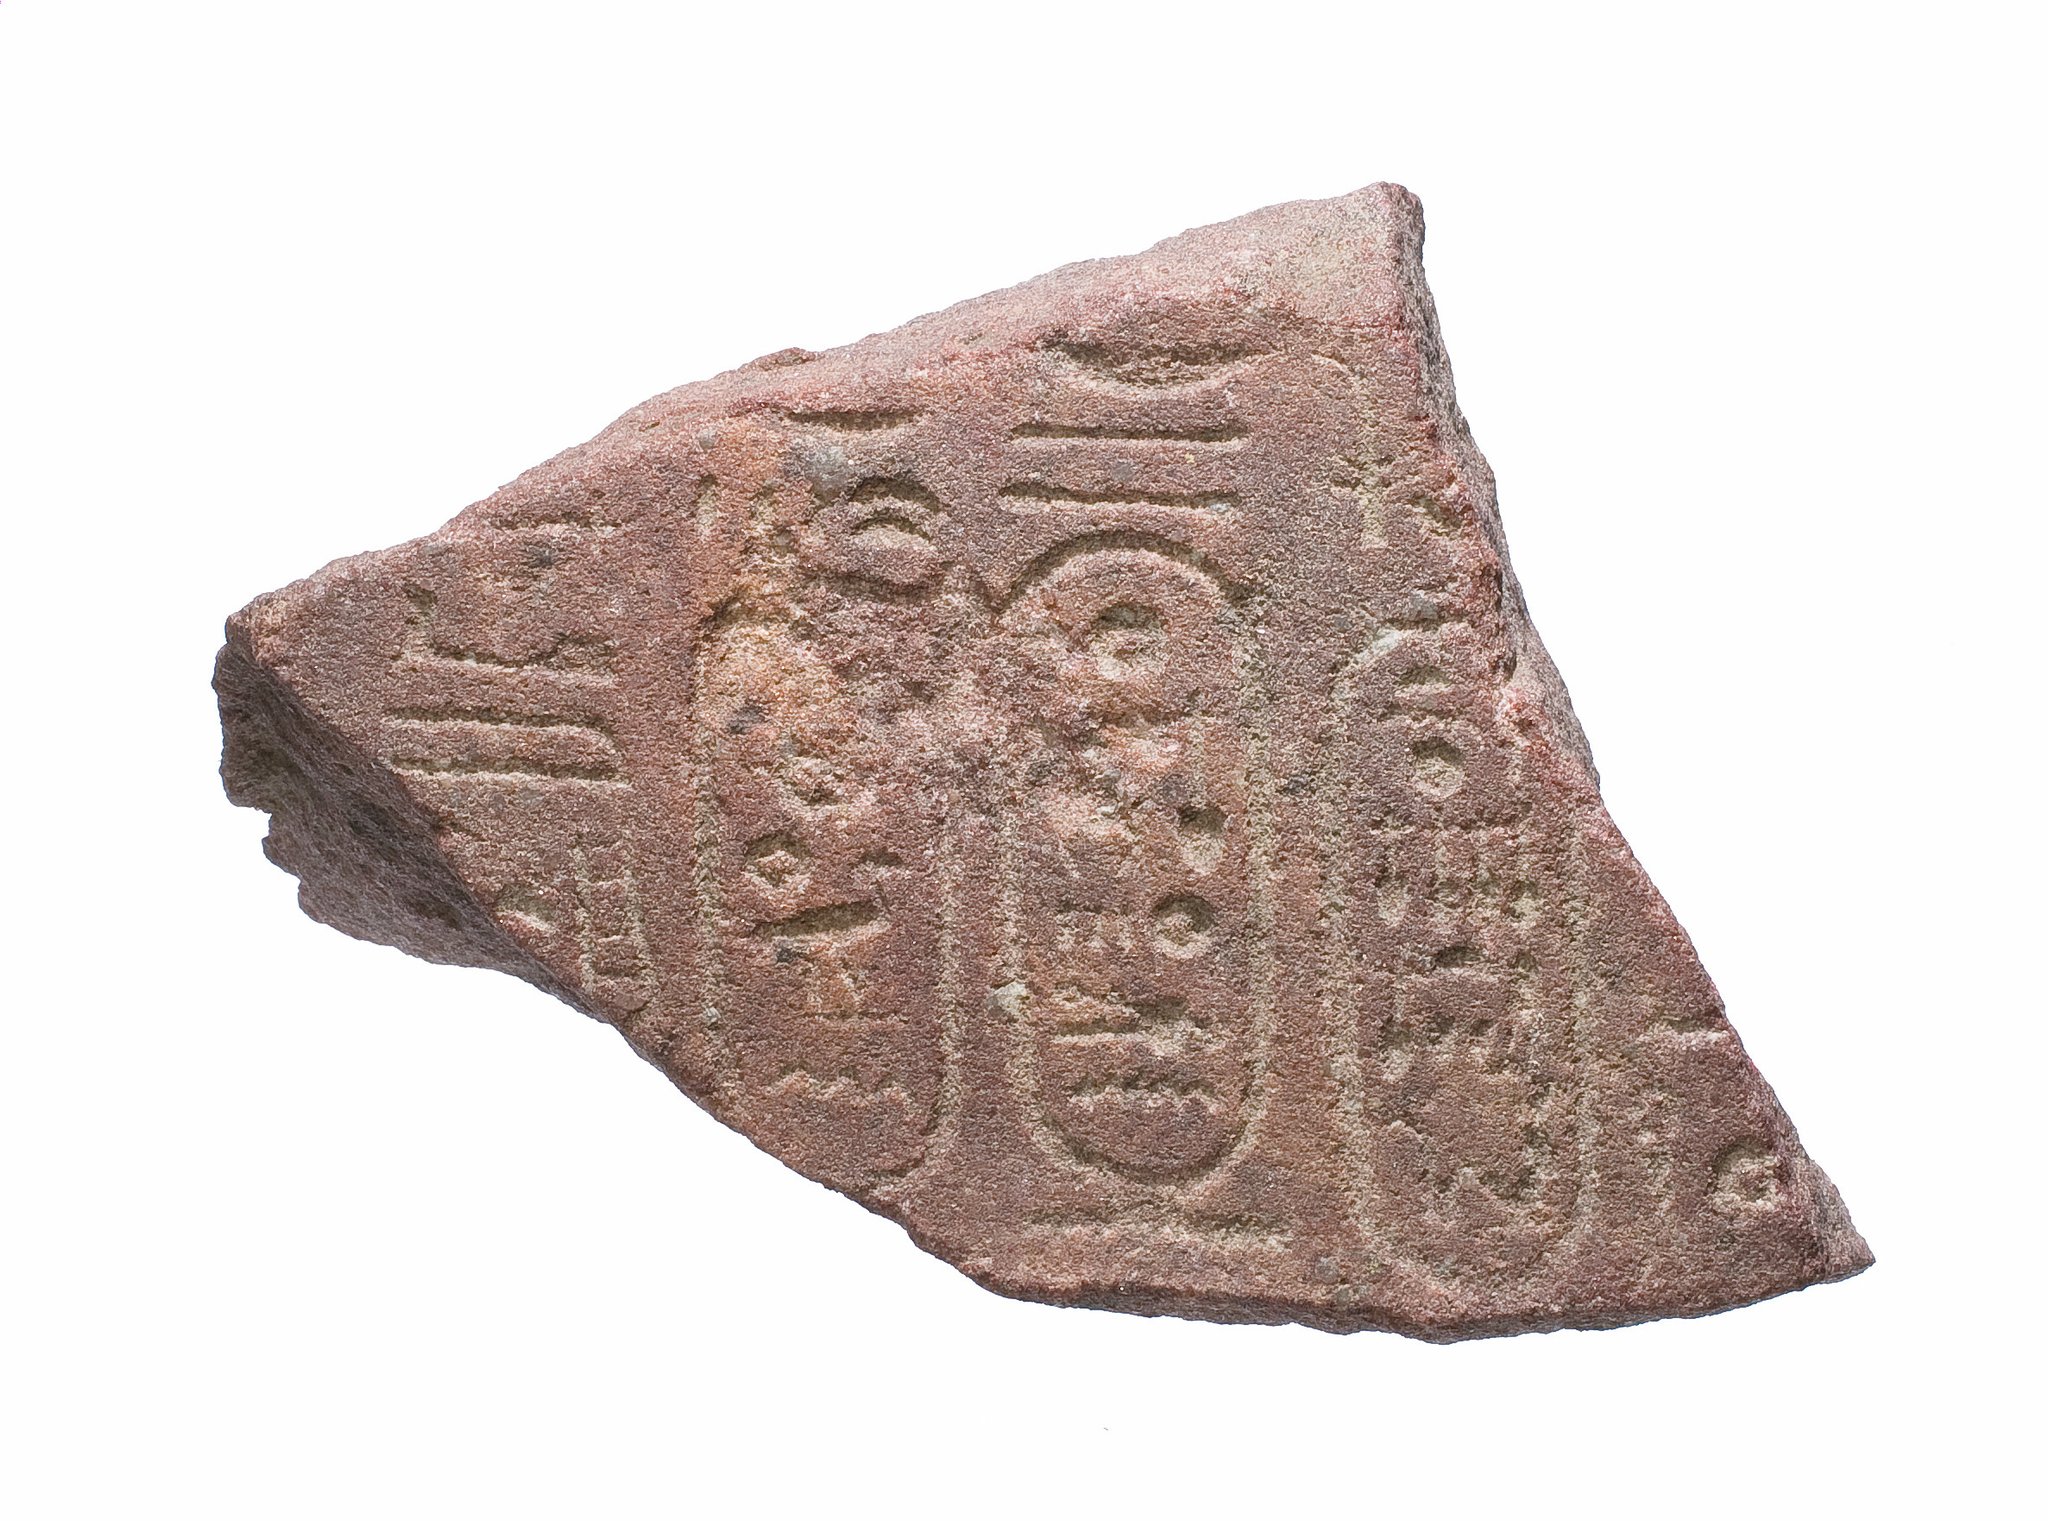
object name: two sided element, name of akhenaten and nefertiti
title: Two-sided curved element with names of Akhenaten and Nefertiti on both sides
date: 1353-1336 BCE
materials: quartzite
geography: egypt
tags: hieroglyphs